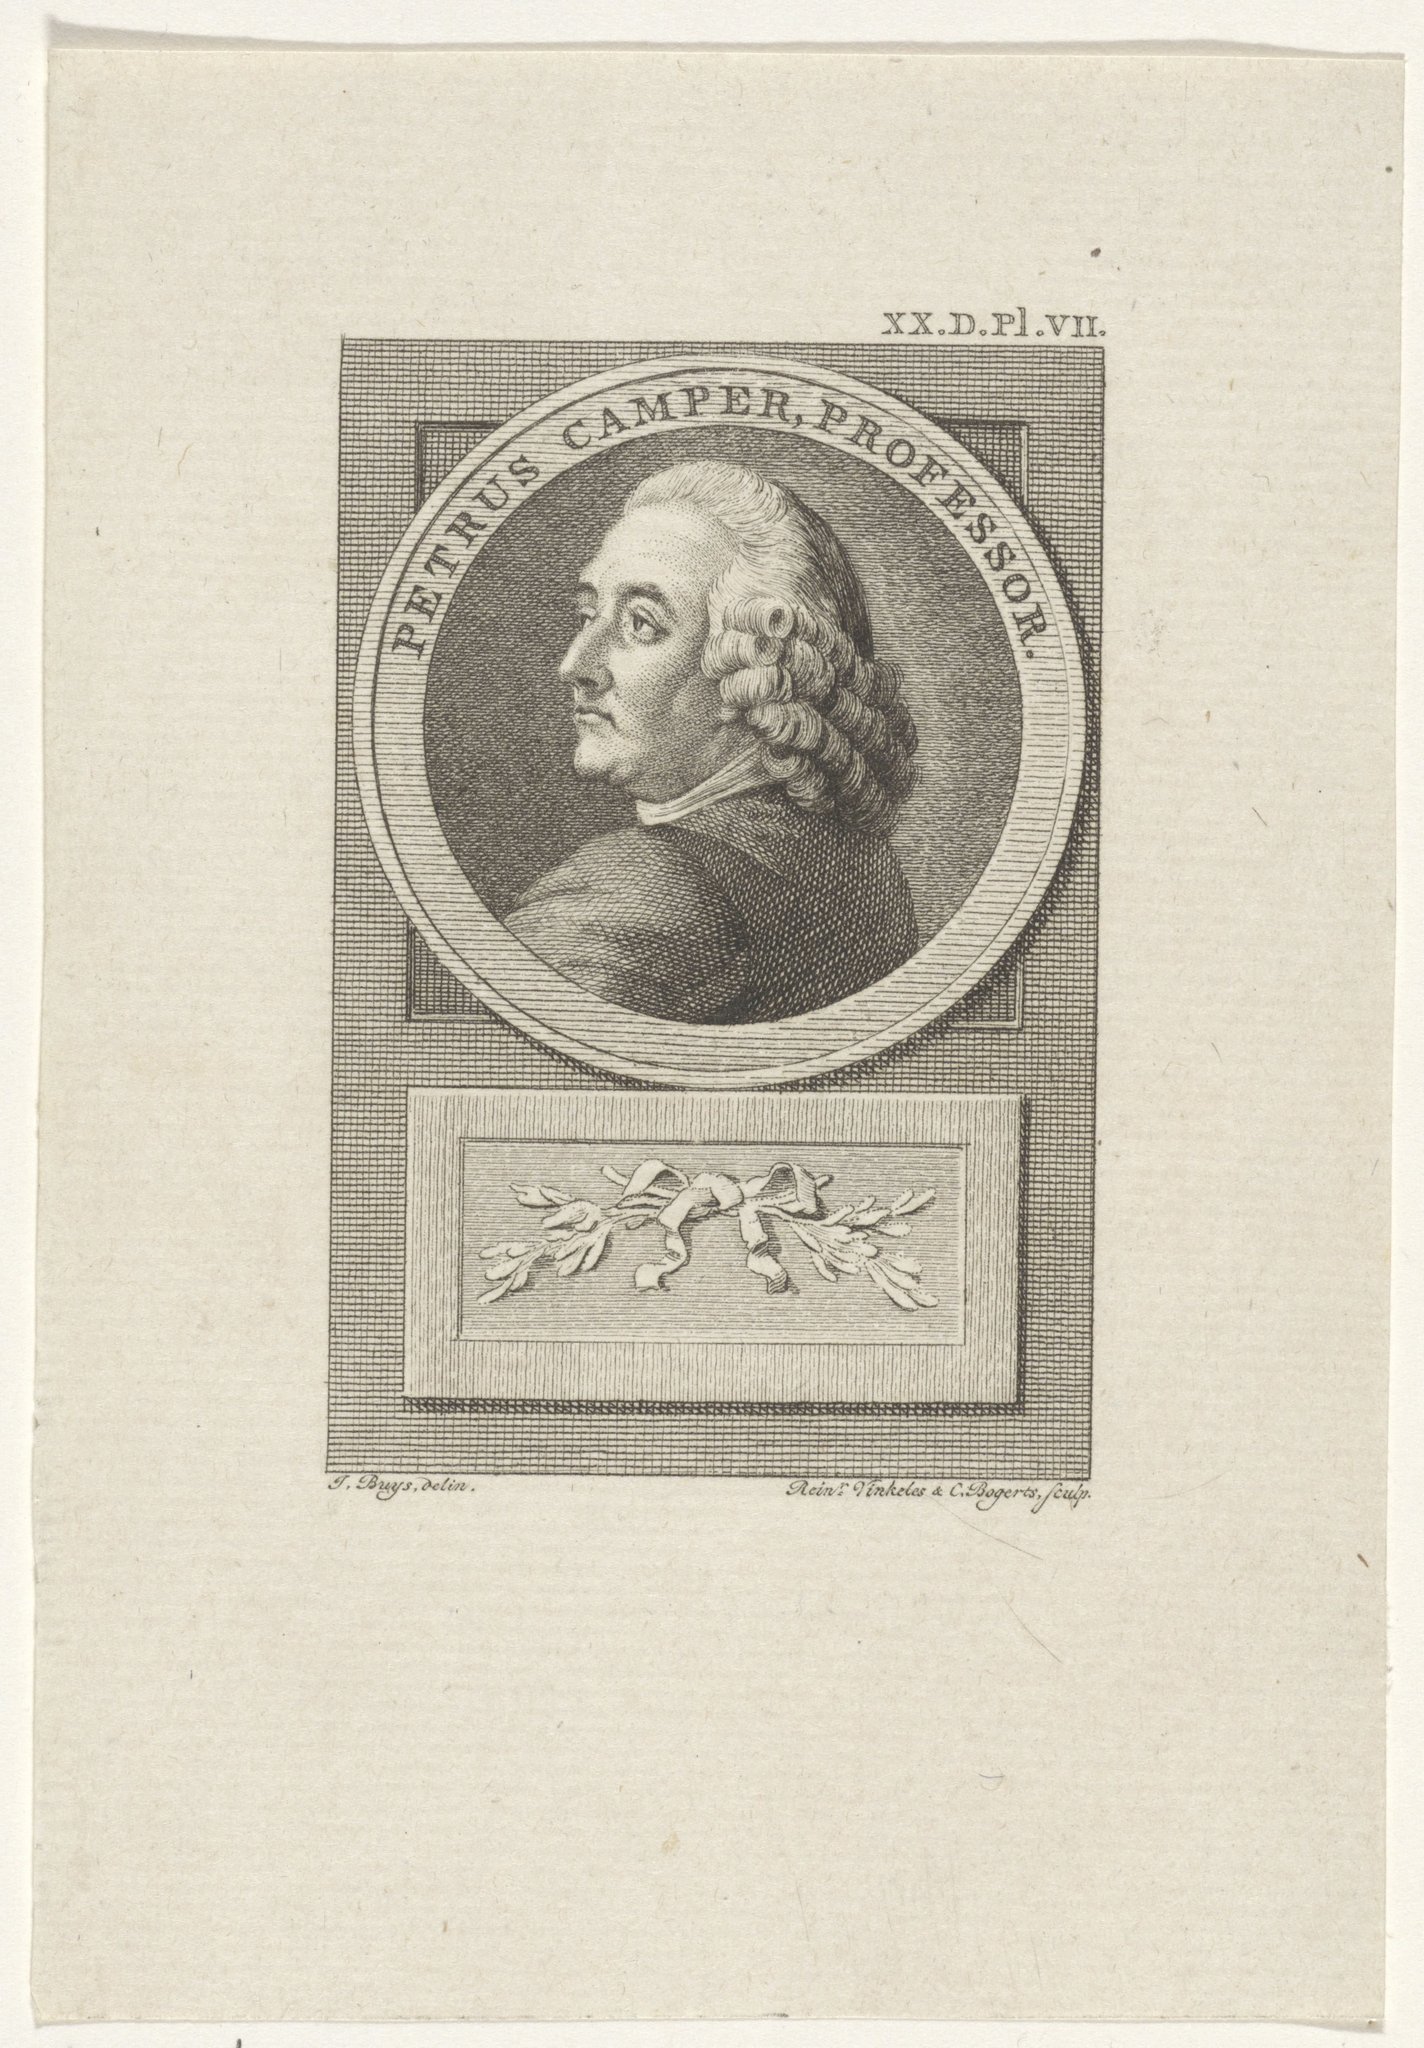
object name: print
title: Portret van Petrus Camper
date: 1783-1795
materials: paper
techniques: engraving, etching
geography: amsterdam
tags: leiden, the hague, print maker, draughtsman, petrus camper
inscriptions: collector's mark: Lugt 2228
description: Prent gebruikt in: Fokke, Jan. Geschiedenissen der Vereenigde Nederlanden voor de vaderlandsche jeugd Ie-XXVste deel. Amsterdam: Johannes Allart, 1783-1795. Deel XX.